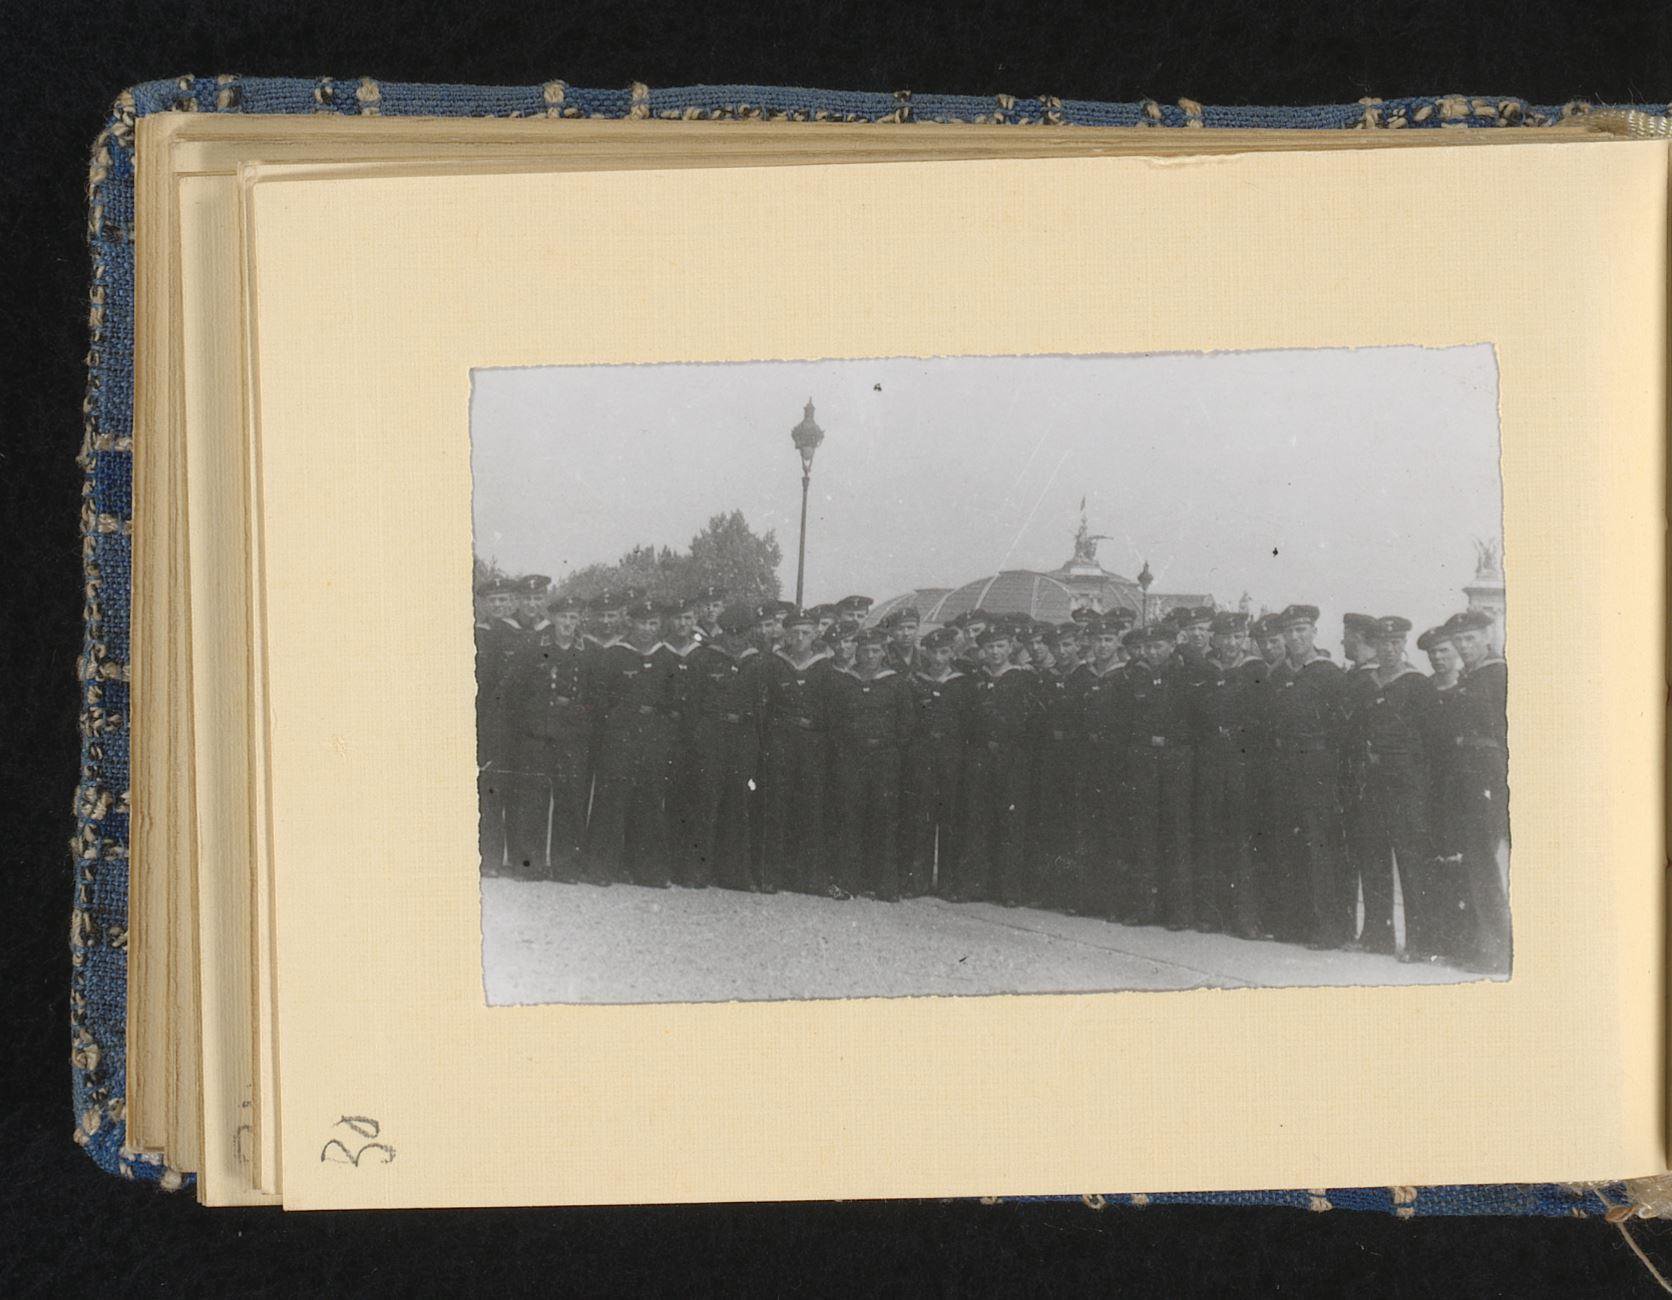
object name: photograph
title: In Parijs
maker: Anonymous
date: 1940-1943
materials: photographic support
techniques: gelatin silver print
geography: paris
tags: the company, the unit, the troop ~ military service, sailor, paris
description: Groepsfoto van de Duitse matrozen in Parijs, voor het Grand Palais. Onderdeel van het fotoalbum over de Kriegsmarine 1940-1943.